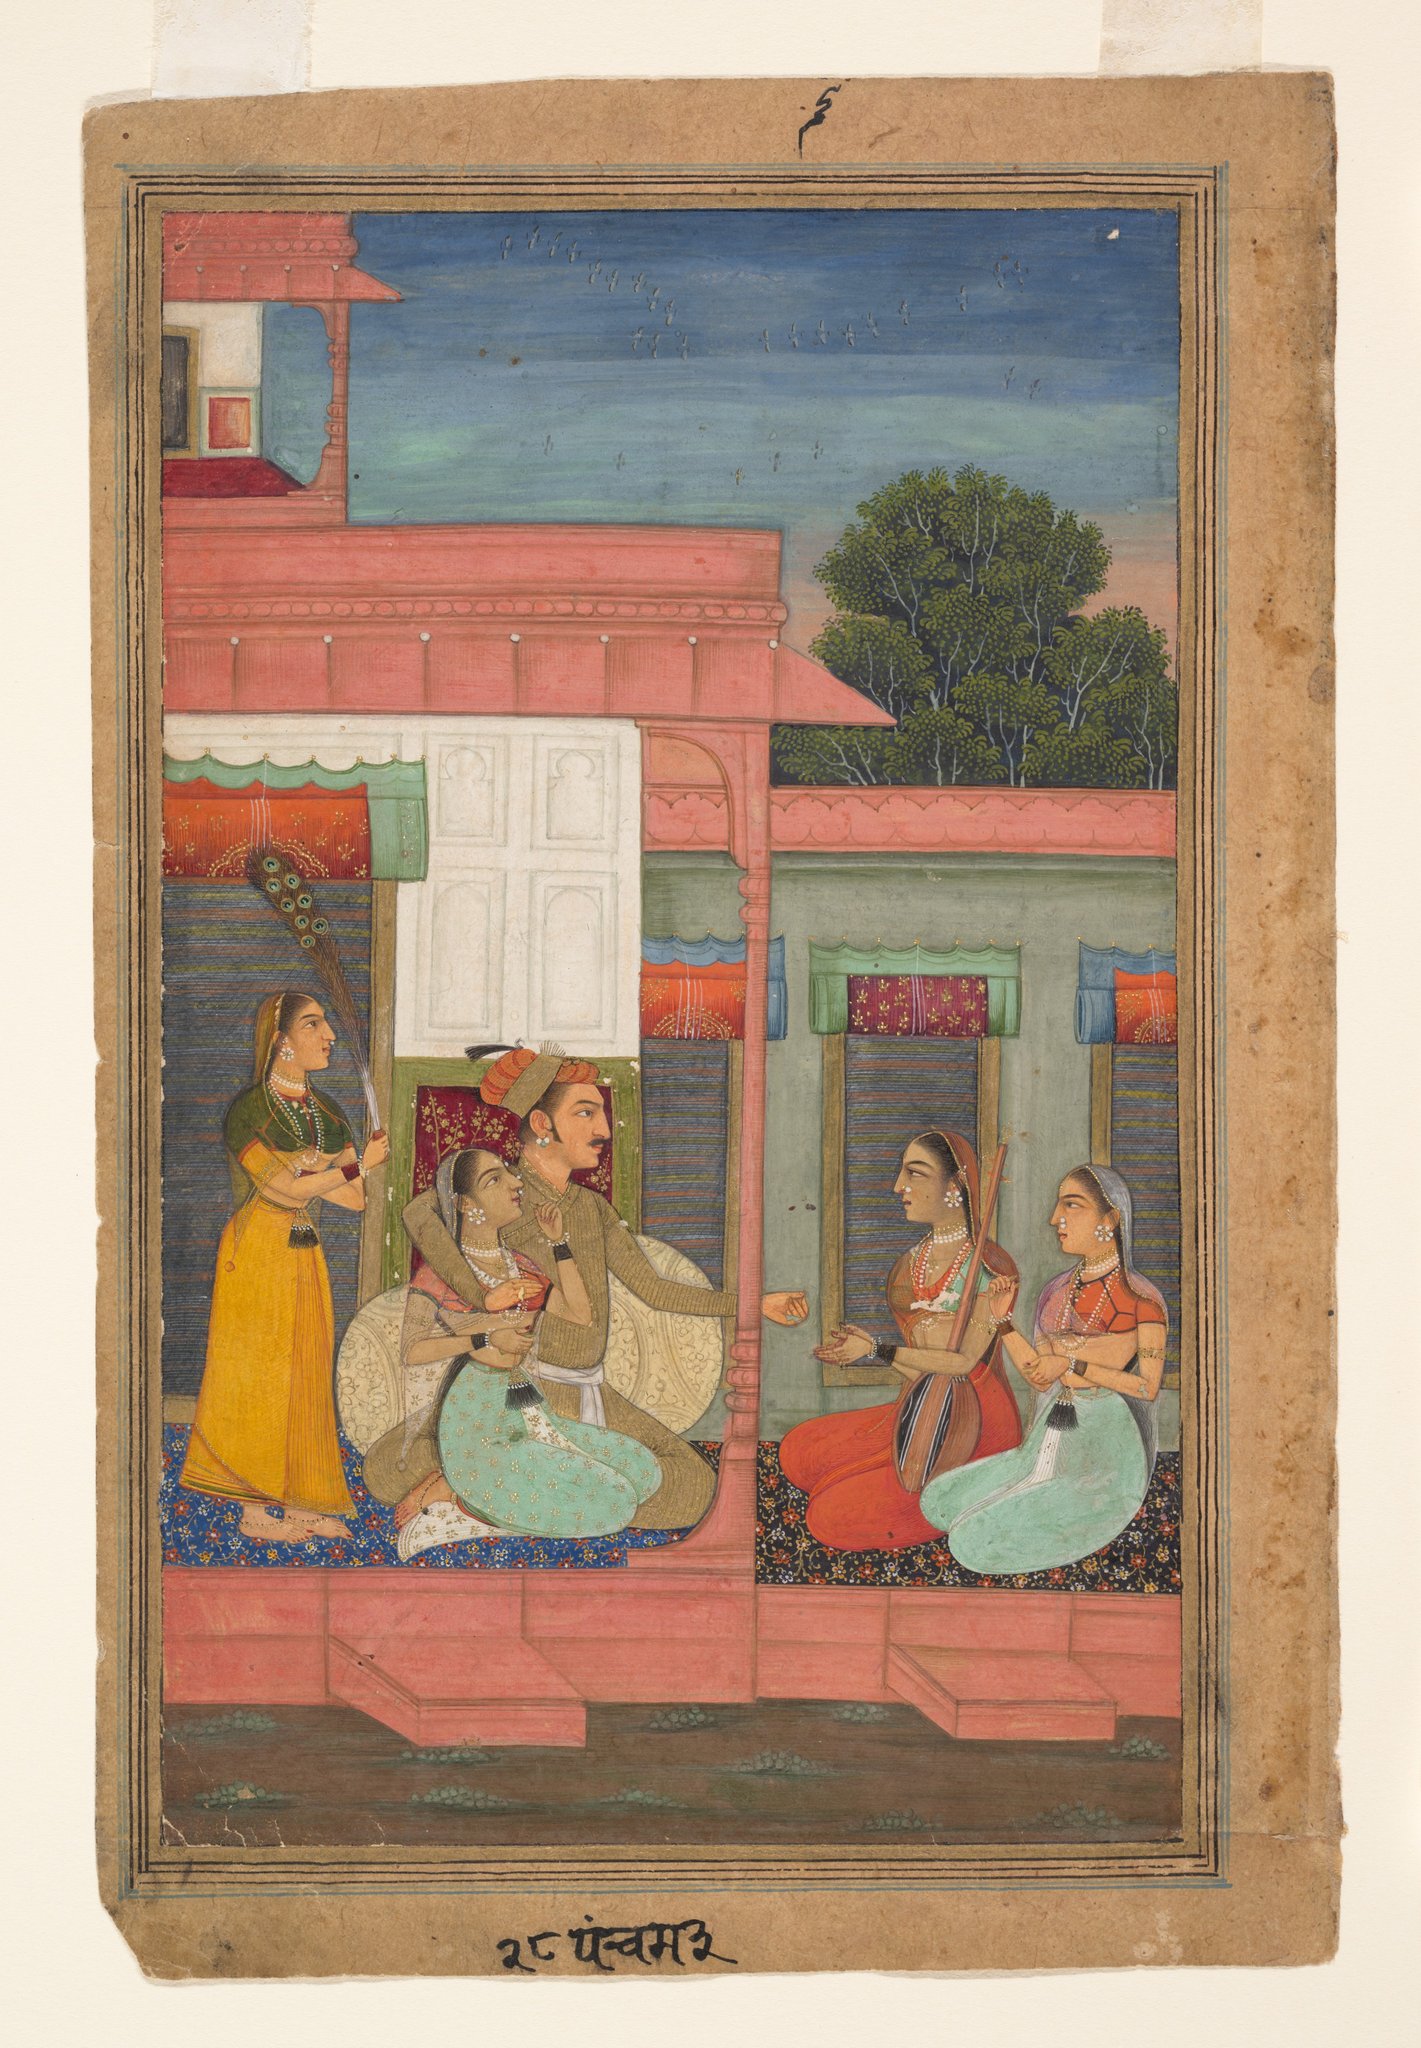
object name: page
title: Panchama Ragini: Page from a Ragamala Series (Garland of Musical Modes)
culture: indian, rajasthani, bikaner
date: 1640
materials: gold, ink, paper, watercolor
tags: musical instruments,men,lovers,women,musicians